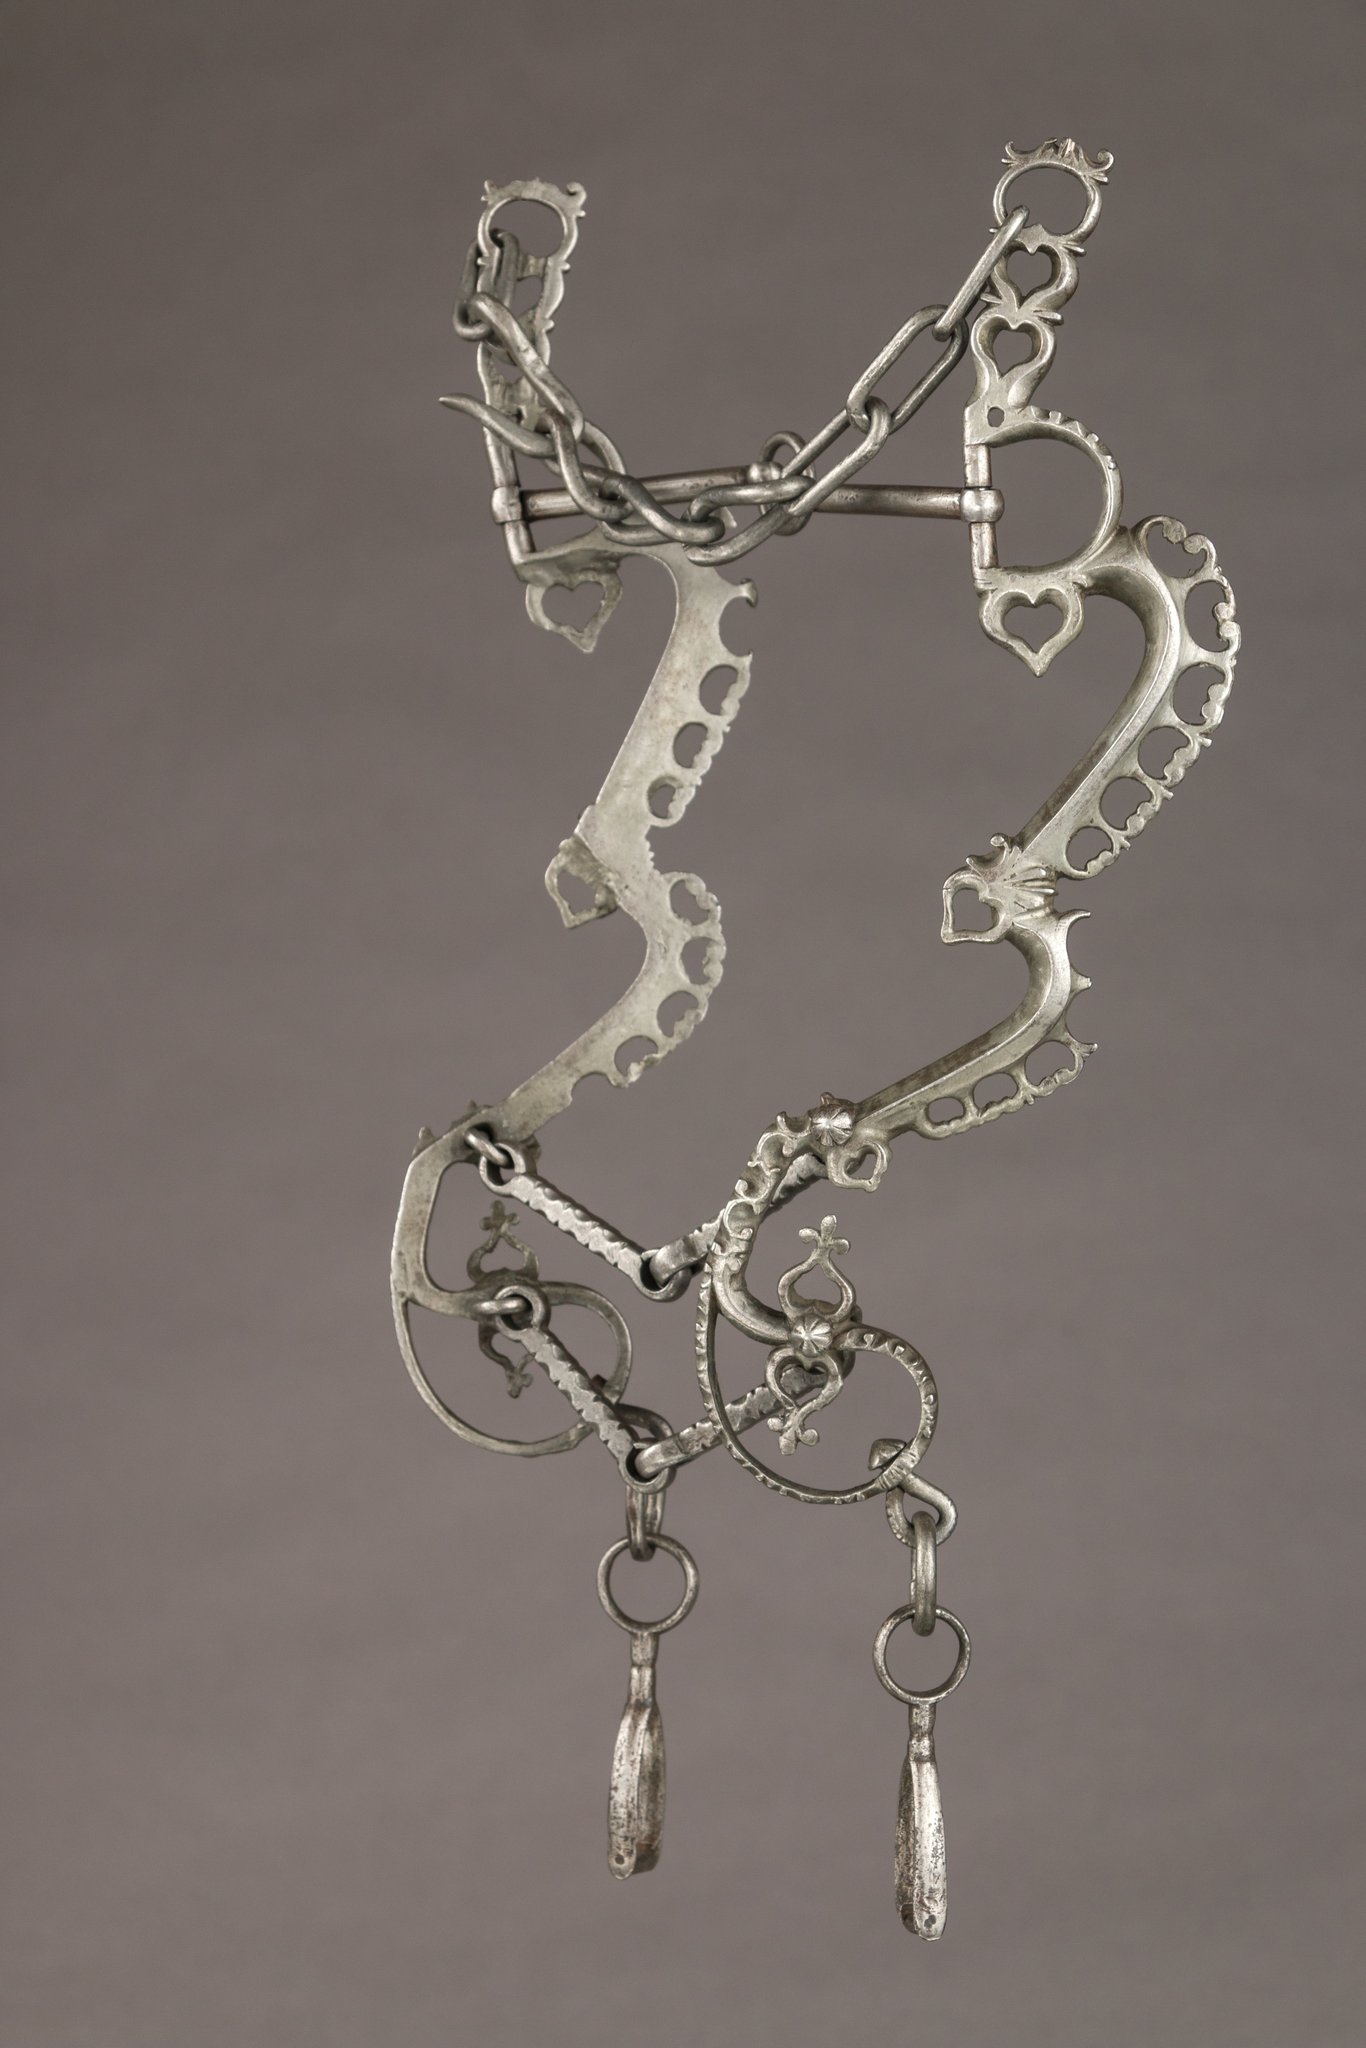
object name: bit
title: Curb Bit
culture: german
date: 1651-1700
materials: metal alloy, tin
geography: germany